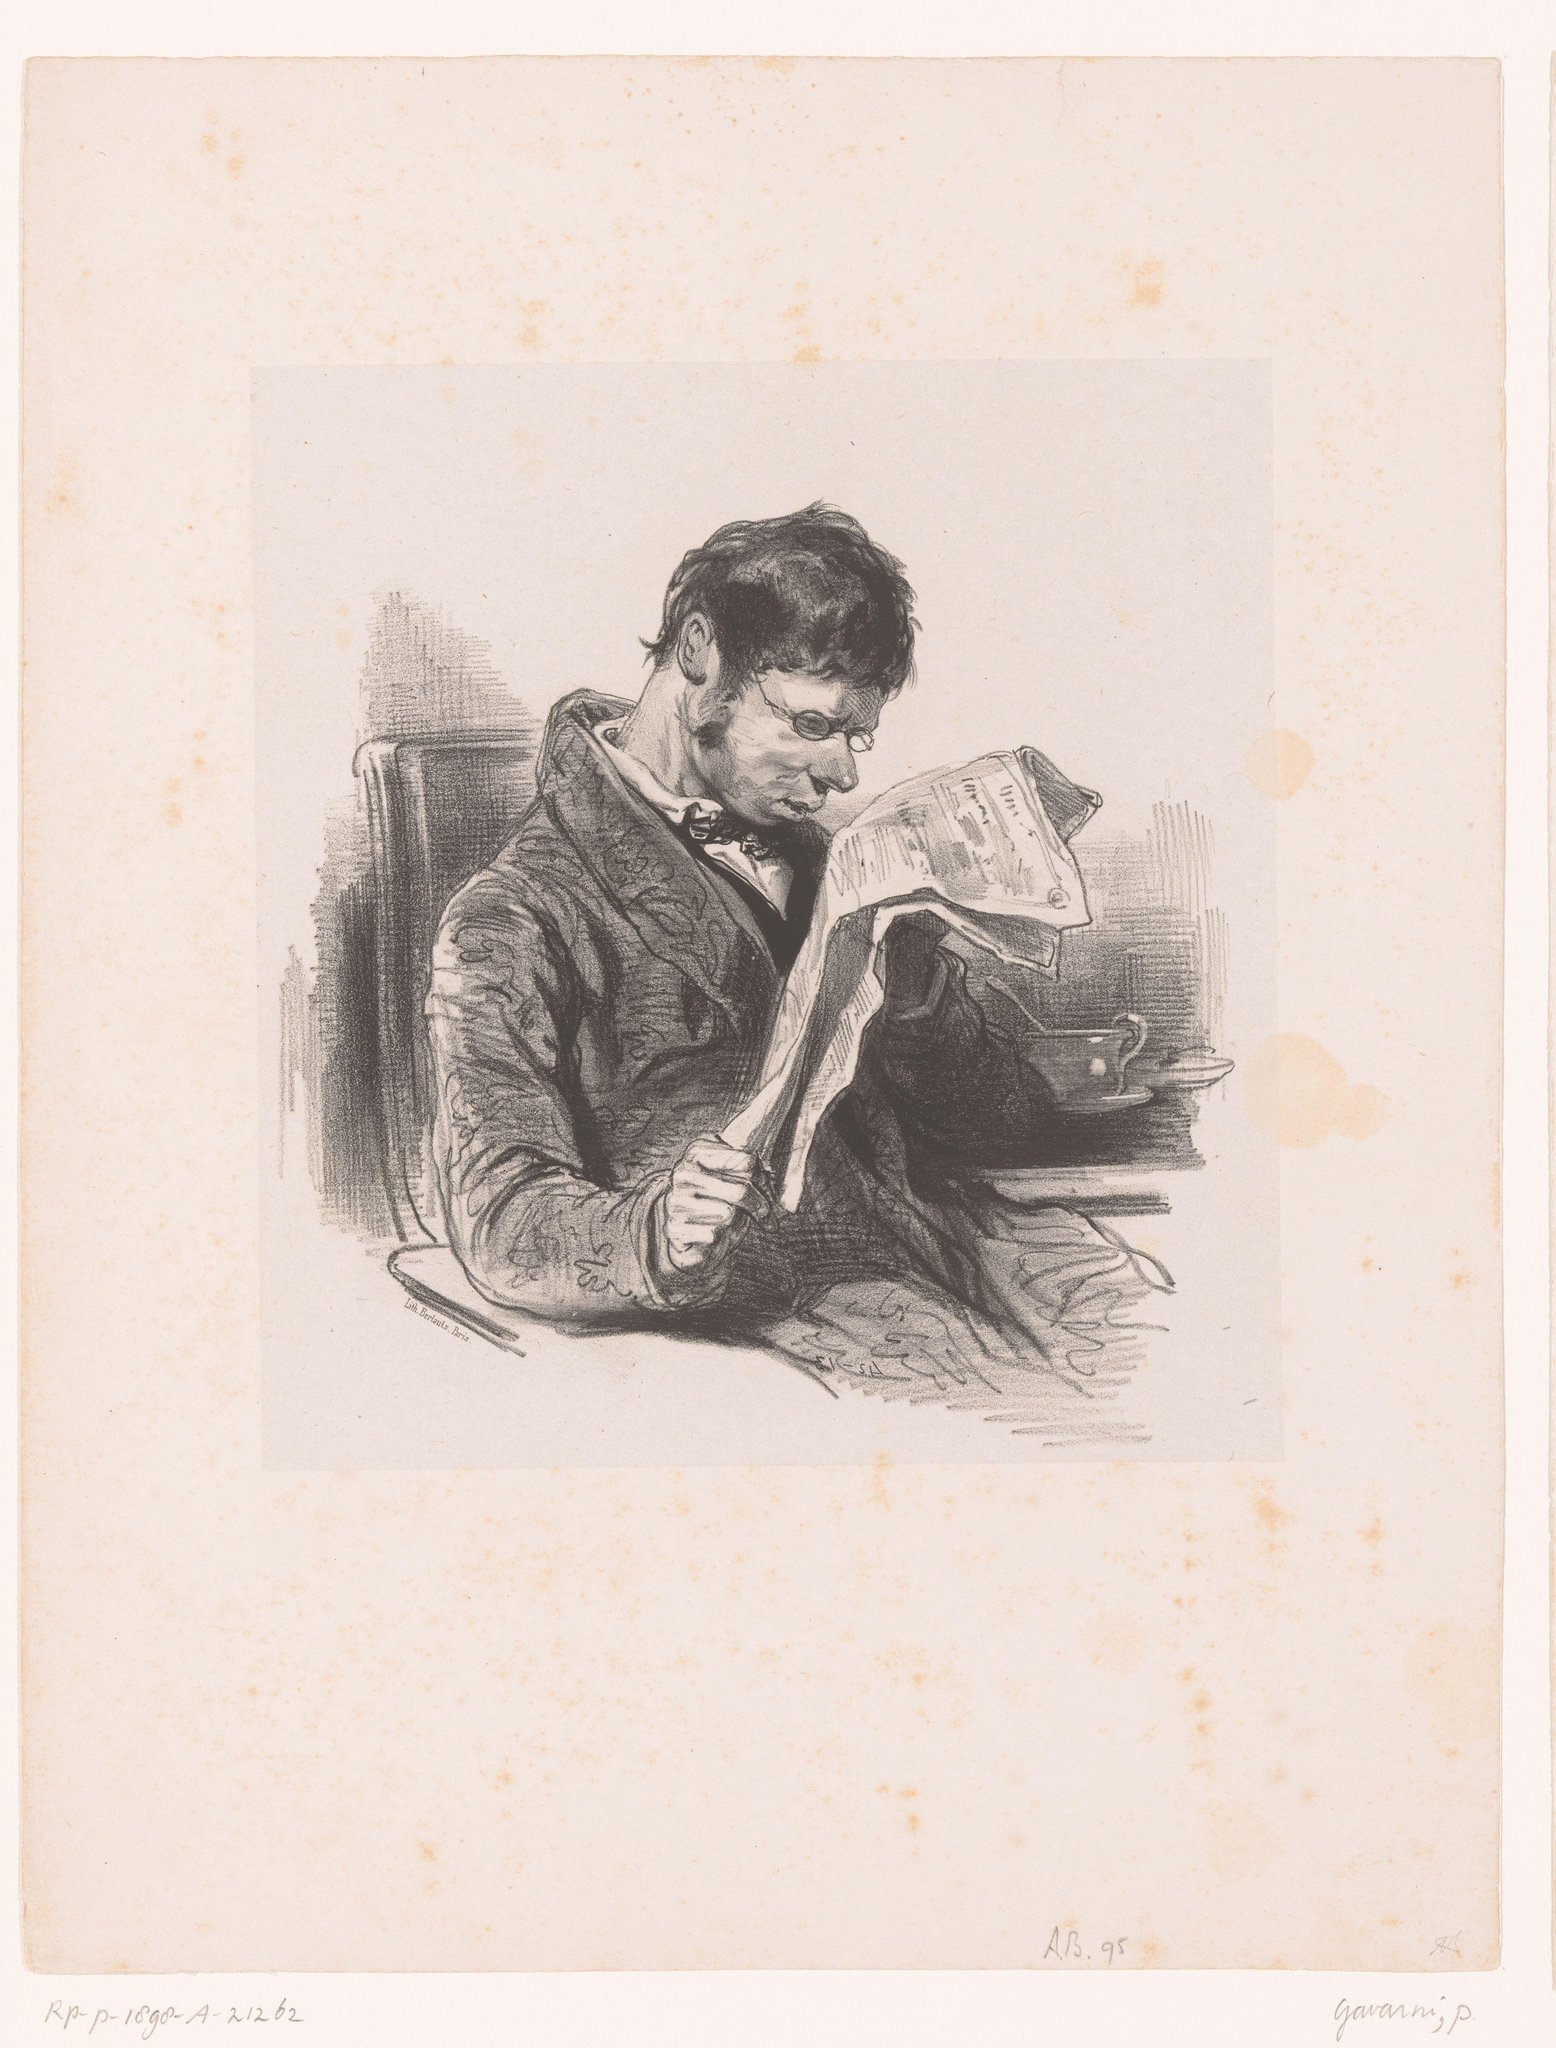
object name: print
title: Man met bril leest de krant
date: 1842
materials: paper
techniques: lithograph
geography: paris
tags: reading, newspaper, news-sheet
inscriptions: collector's mark: Lugt 964